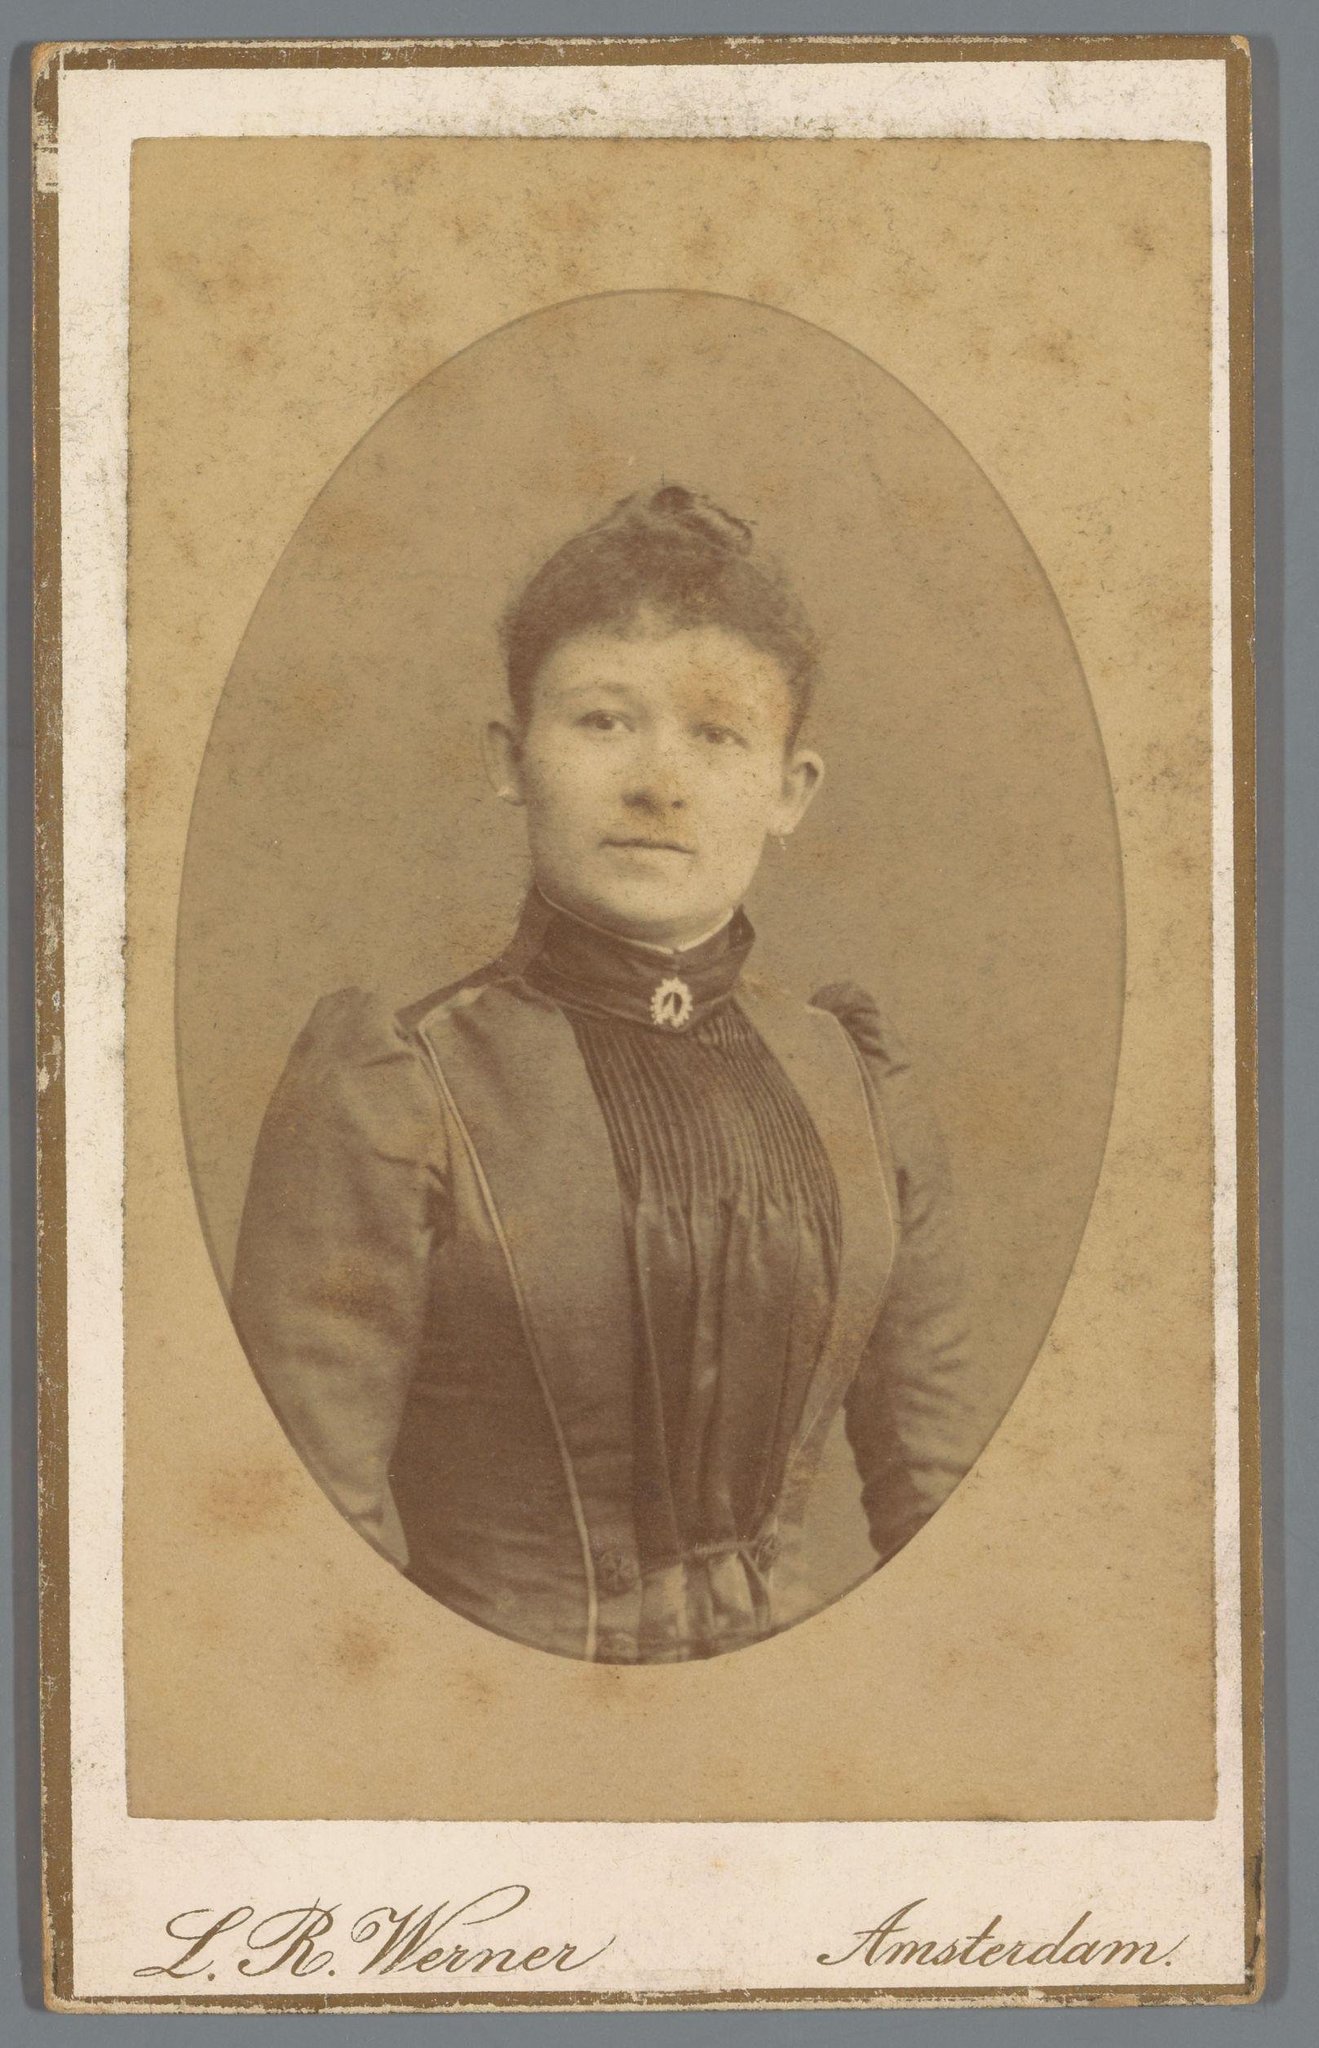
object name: carte de visite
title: Portret van een onbekende jonge vrouw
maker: louis robert werner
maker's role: fotograaf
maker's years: 1834-1896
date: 1878-1886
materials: cardboard, paper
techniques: albumen print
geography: amsterdam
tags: adolescent, young woman, maiden, anonymous historical person portrayed, amsterdam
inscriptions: inscription: ‘L.R. Werner/ voorheen P. Carstensen/ Amsterdam/ Nieuwendijk H.150./ Nabestellingen en Vergrotingen,/ ook van anderen Portretten, kunnen iederen tijd geleverd worden.’, inscription: ‘L.R. Werner Amsterdam’